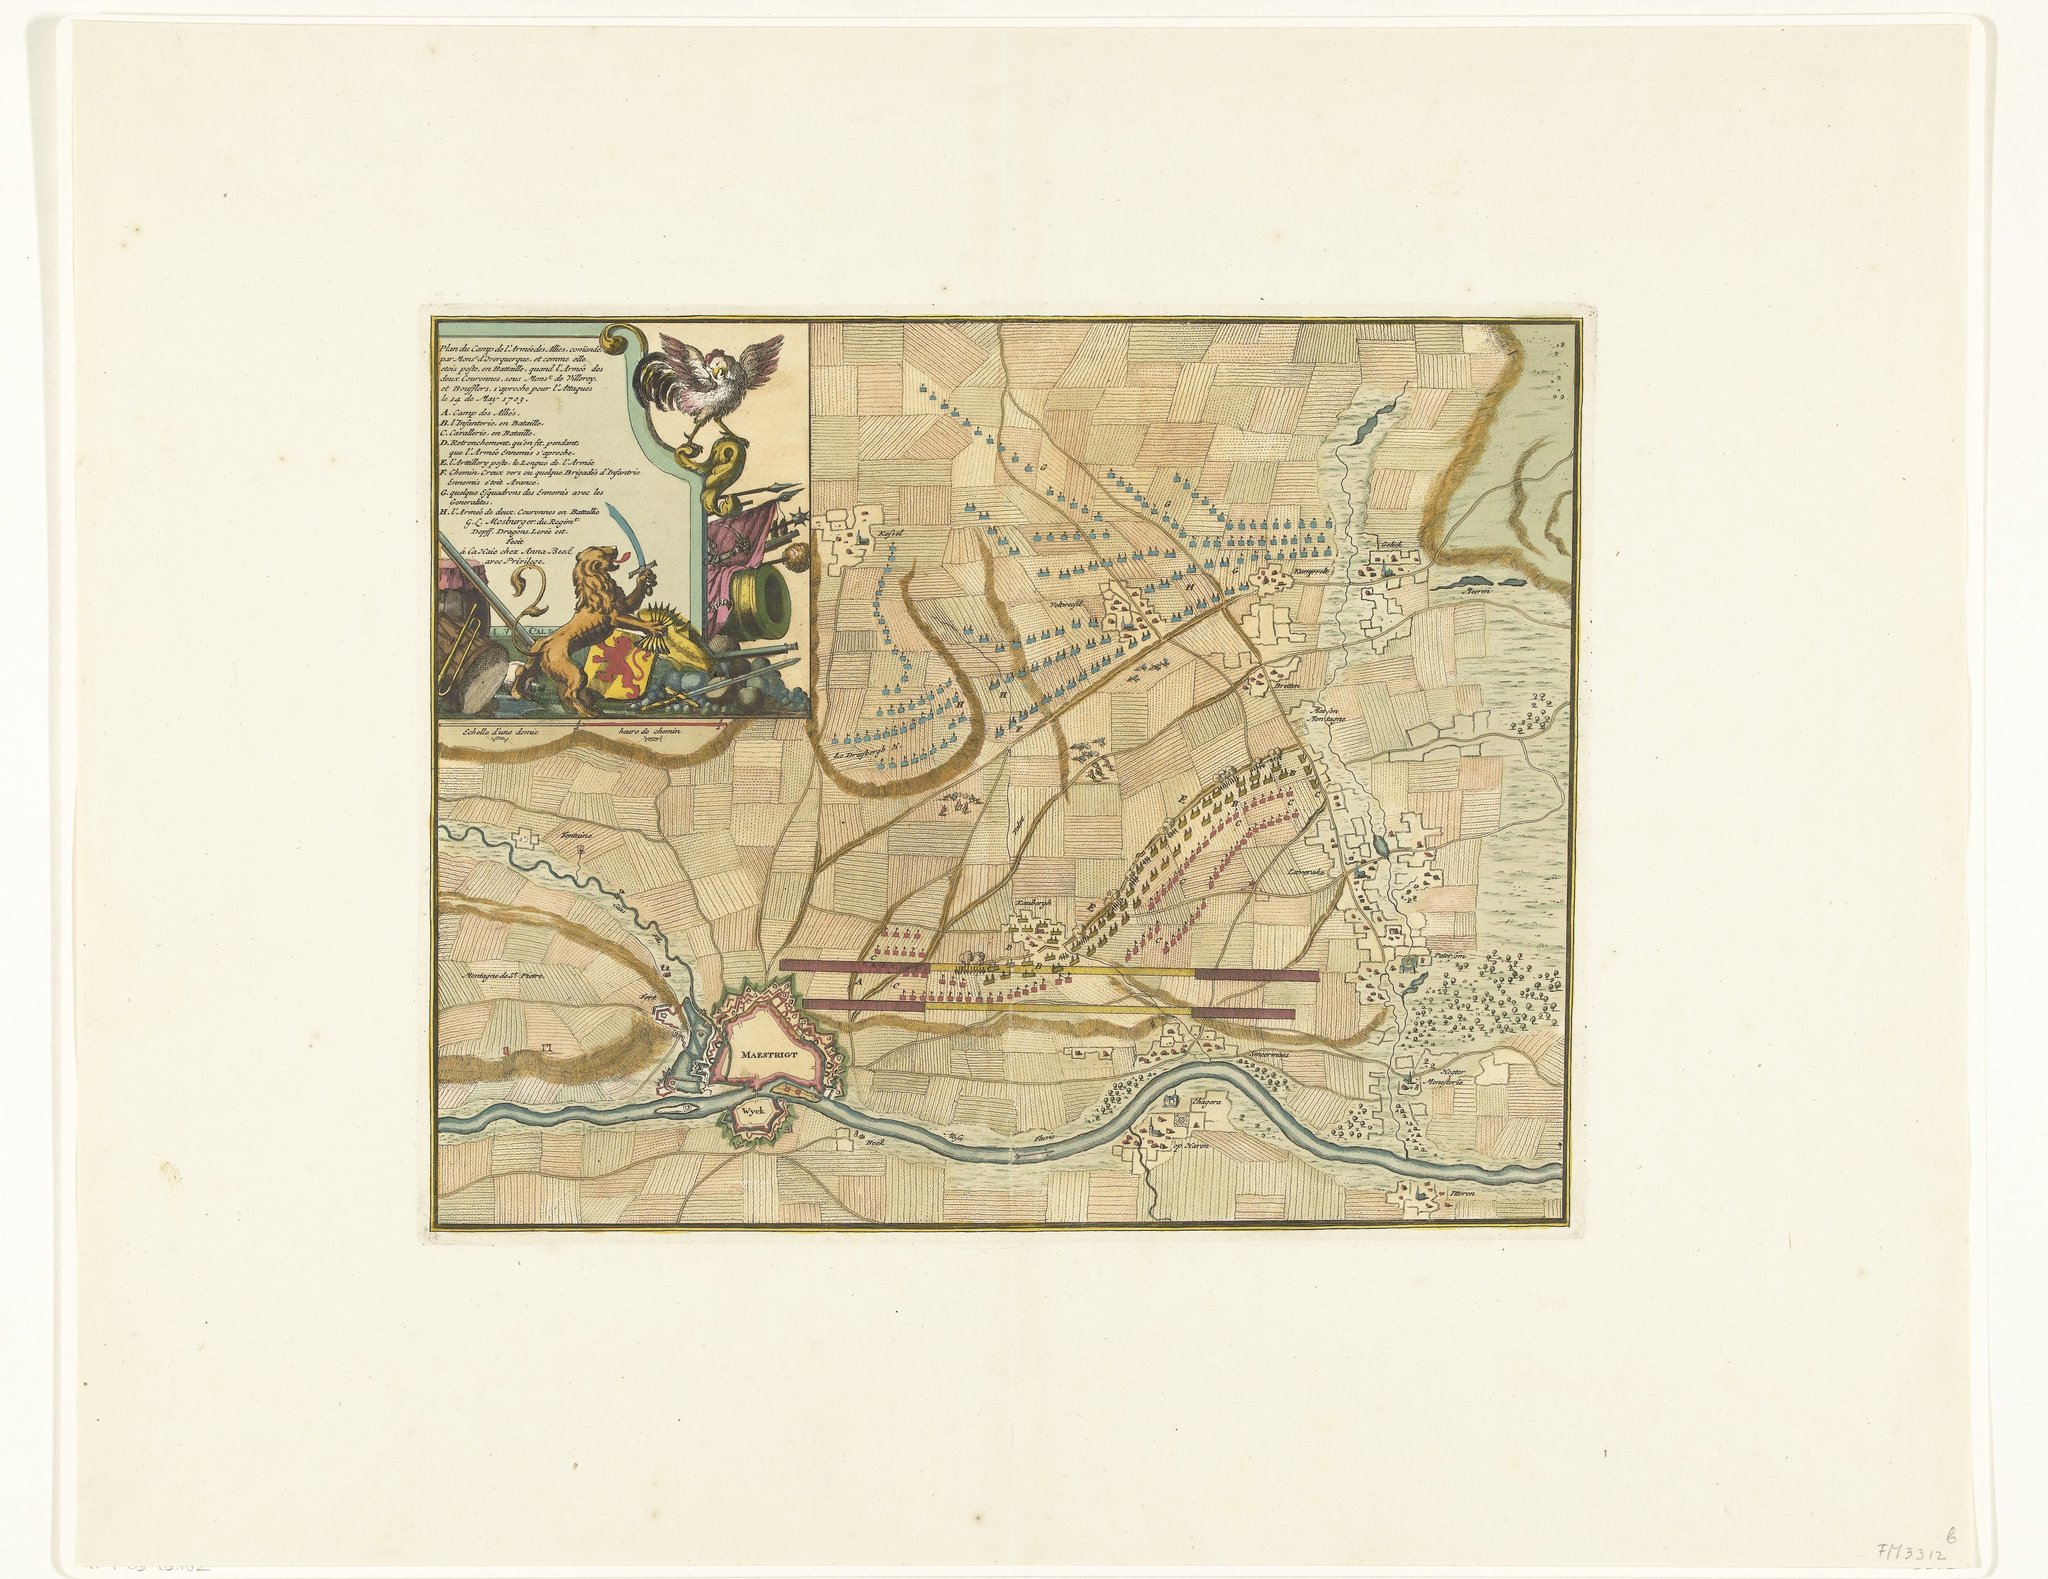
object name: map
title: Plan du Camp de l'Armée des Allies, com[m]ande par Monsr. d'Overquerque (...) 14 de May 1703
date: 1703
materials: paper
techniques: etching, hand coloring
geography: northern netherlands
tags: maps of separate countries or regions, siege, position war, maastricht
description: Kaart met het plan van het legerkamp van de Geallieerden onder de Graaf van Ouwerkerk voor Maastricht, 14 mei 1703. Linksboven een cartouche voor de legenda A-H met de Hollandse Leeuw die de Franse Haan met wapens bedreigt.